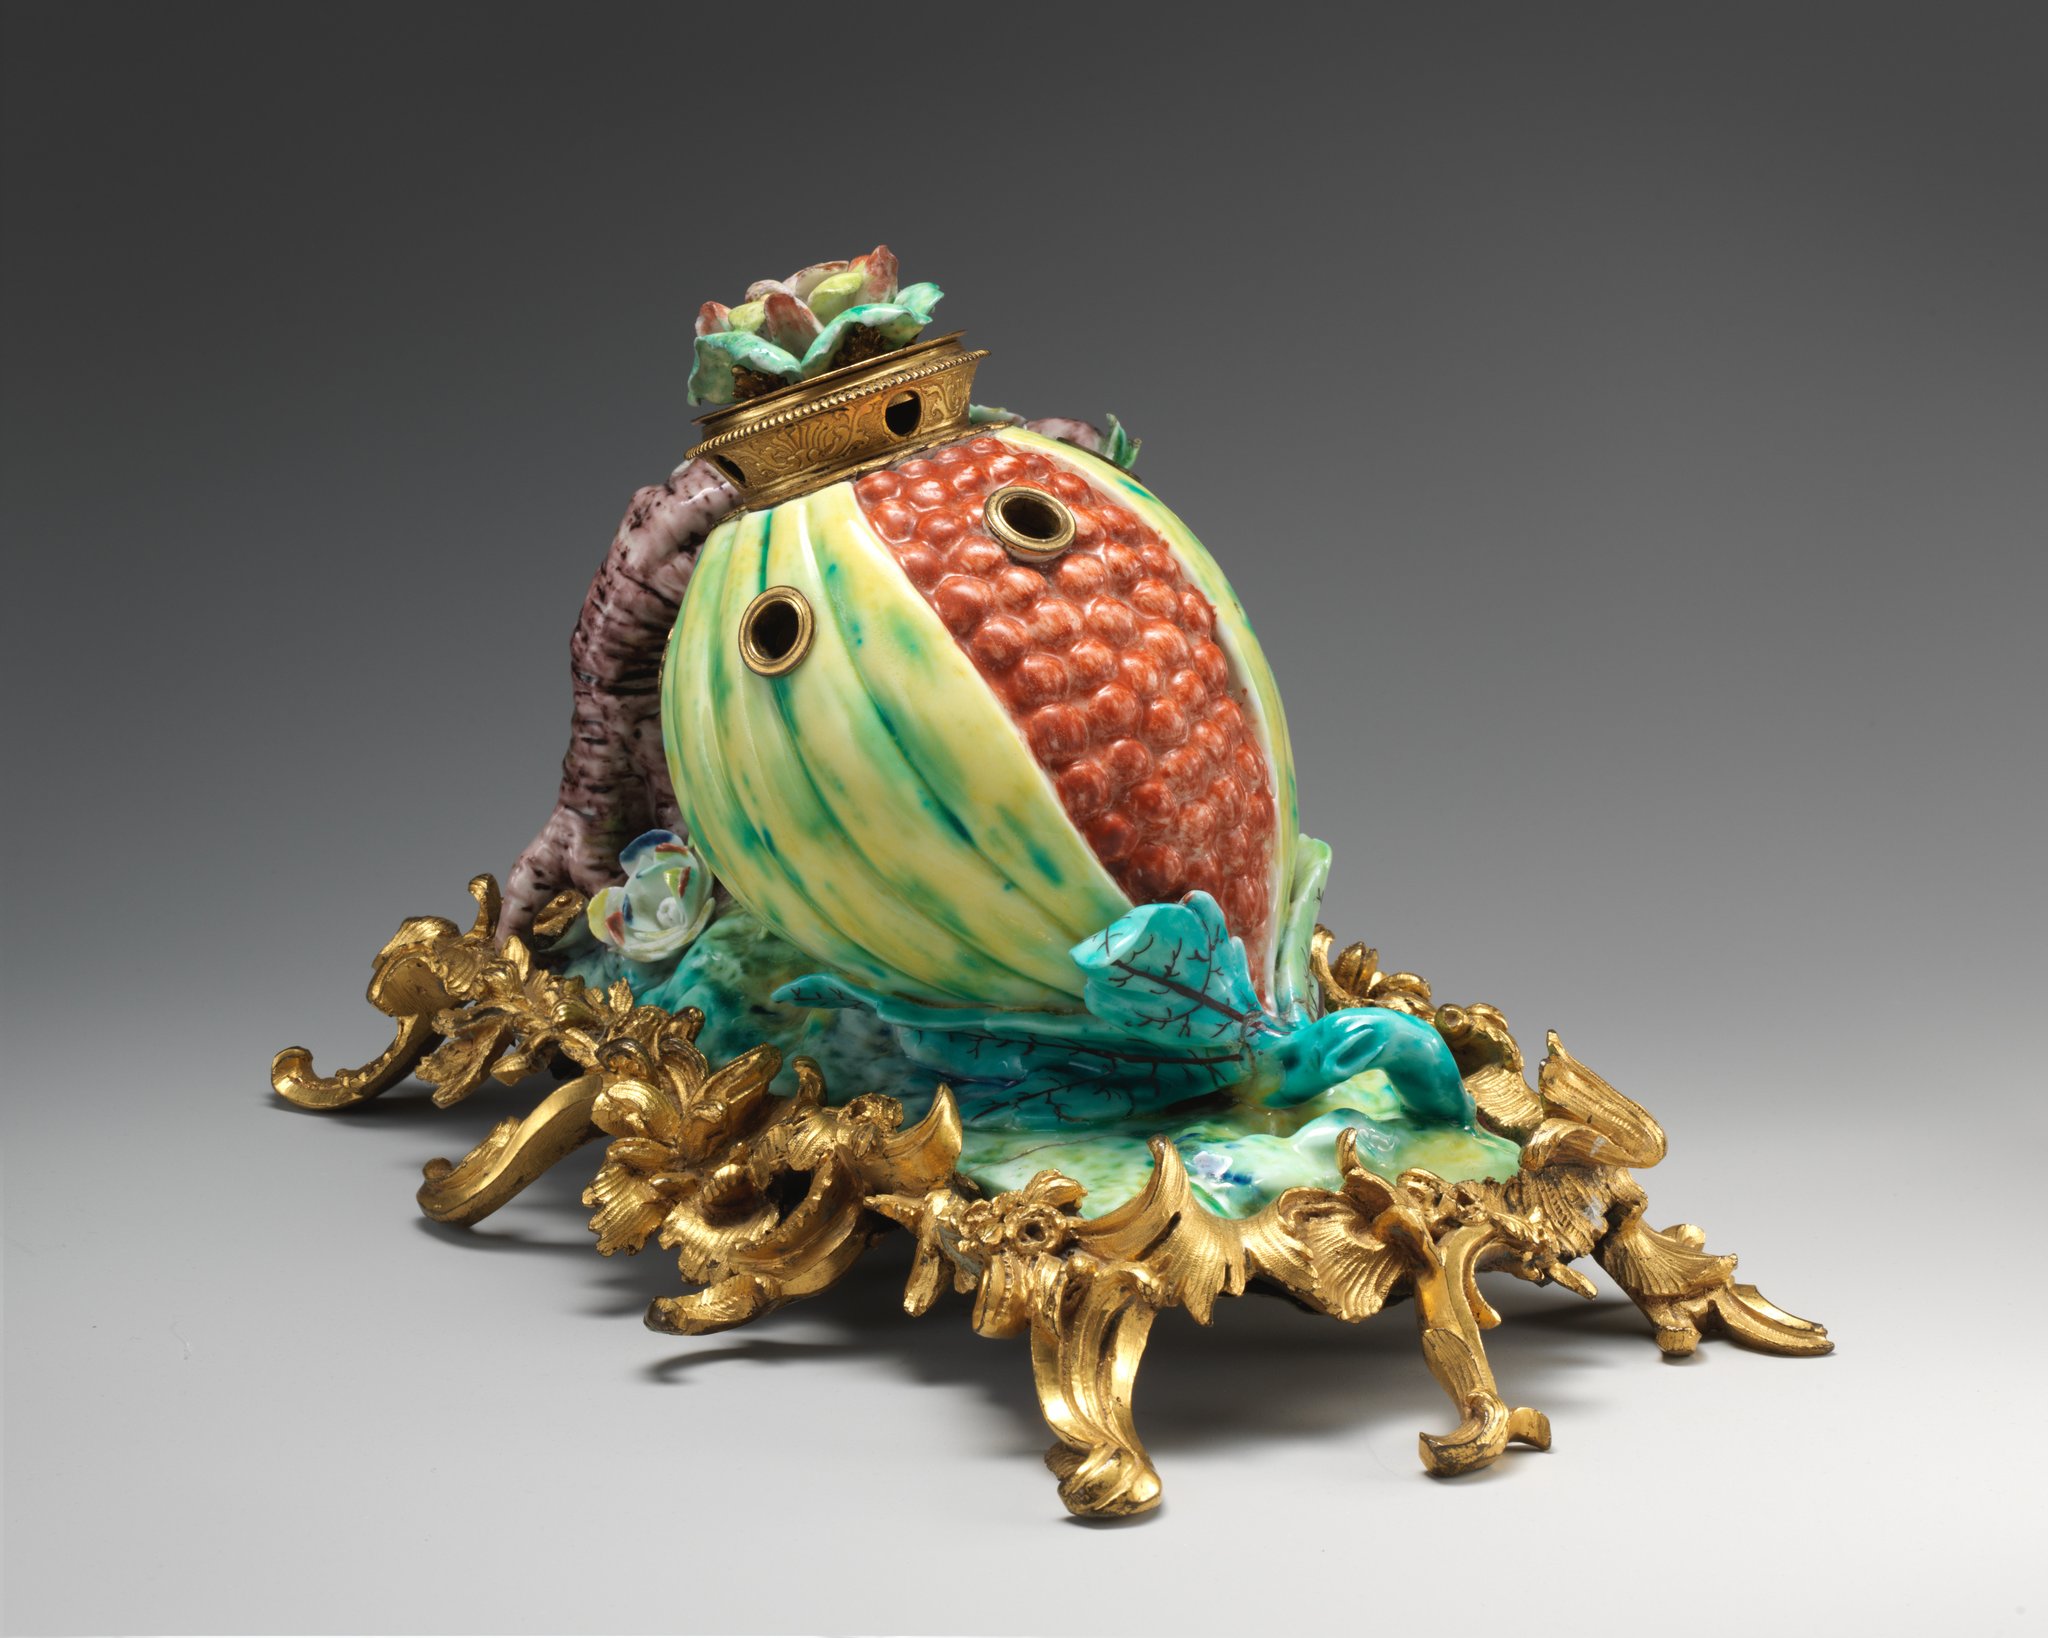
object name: inkstand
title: Inkstand in the form of a pomegranate in a gilt-bronze mount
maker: chantilly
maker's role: maker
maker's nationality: french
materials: bronze, soft paste porcelain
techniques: gilding